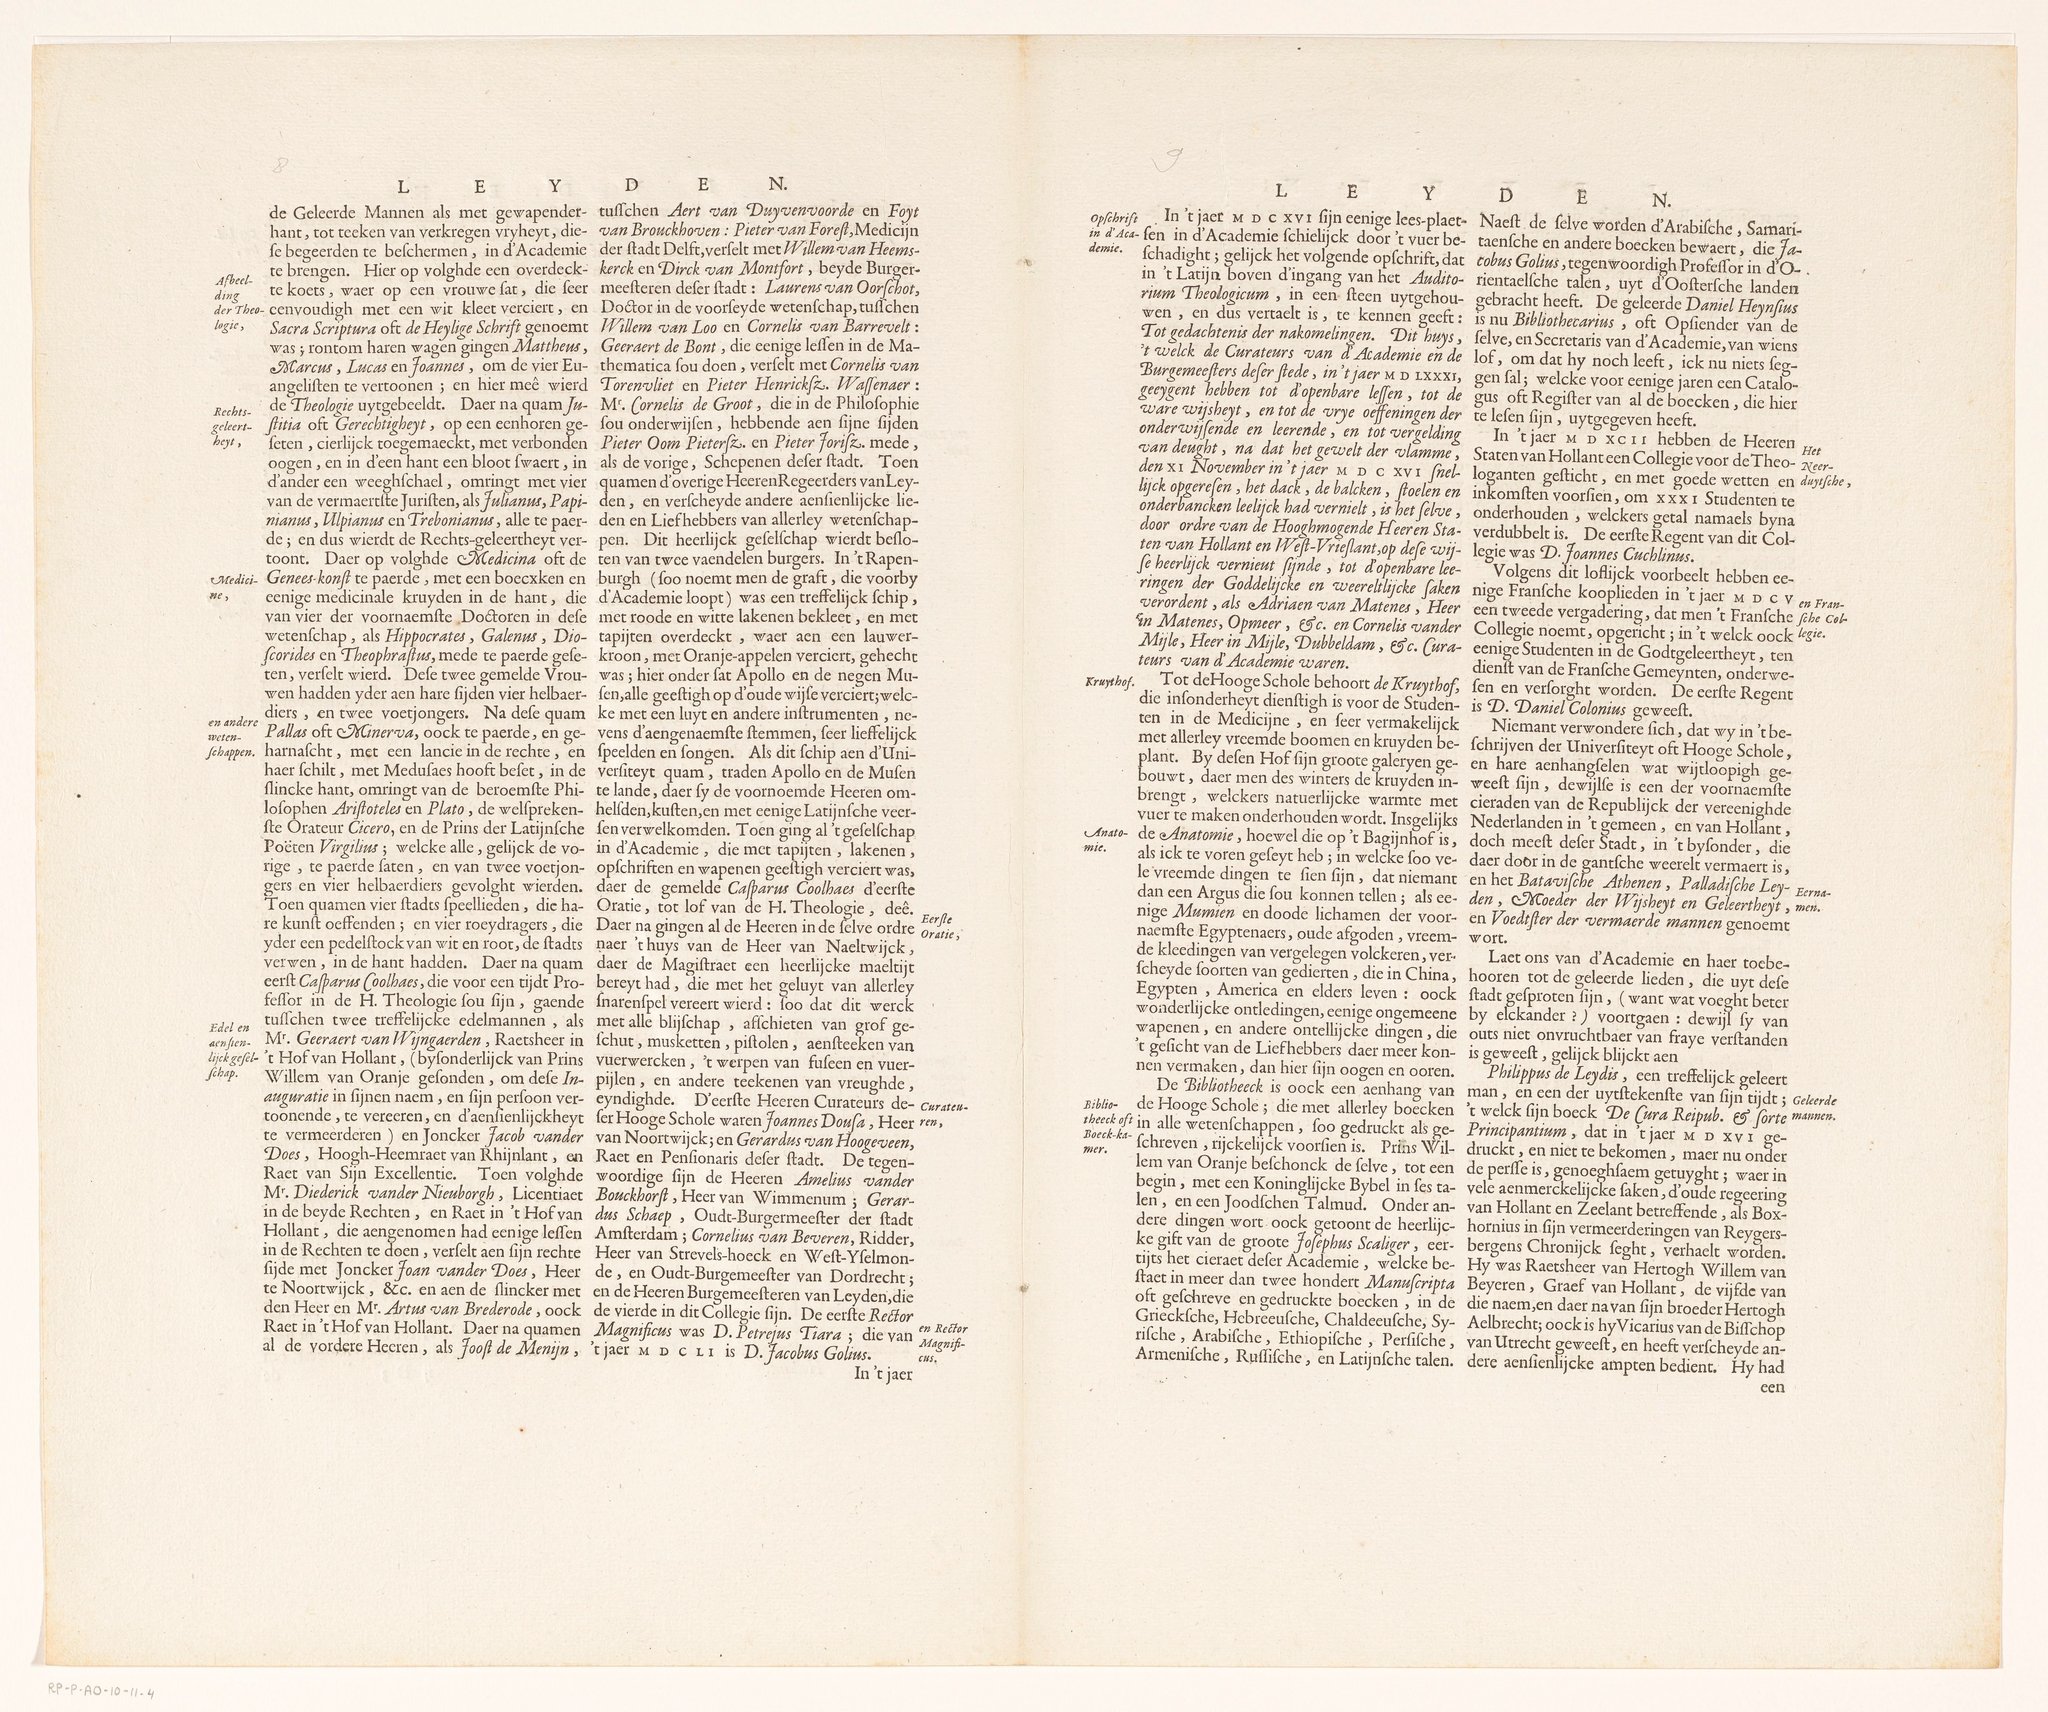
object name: text sheet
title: Leyden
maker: johannes willemszoon blaeu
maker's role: printer, publisher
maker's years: 1596-1673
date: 1652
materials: paper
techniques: letterpress printing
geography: amsterdam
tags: leiden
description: Tekst gebruikt in: Blaeu, Johannes Willemszoon. Toonneel der steden van de Vereenighde Nederlanden. 2 delen. Amsterdam: Johannes Willemszoon Blaeu, 1652, dl. 1. Zie ook RP-P-AO-10-11-2, RP-P-AO-10-11-3 en RP-P-AO-10-11-5.